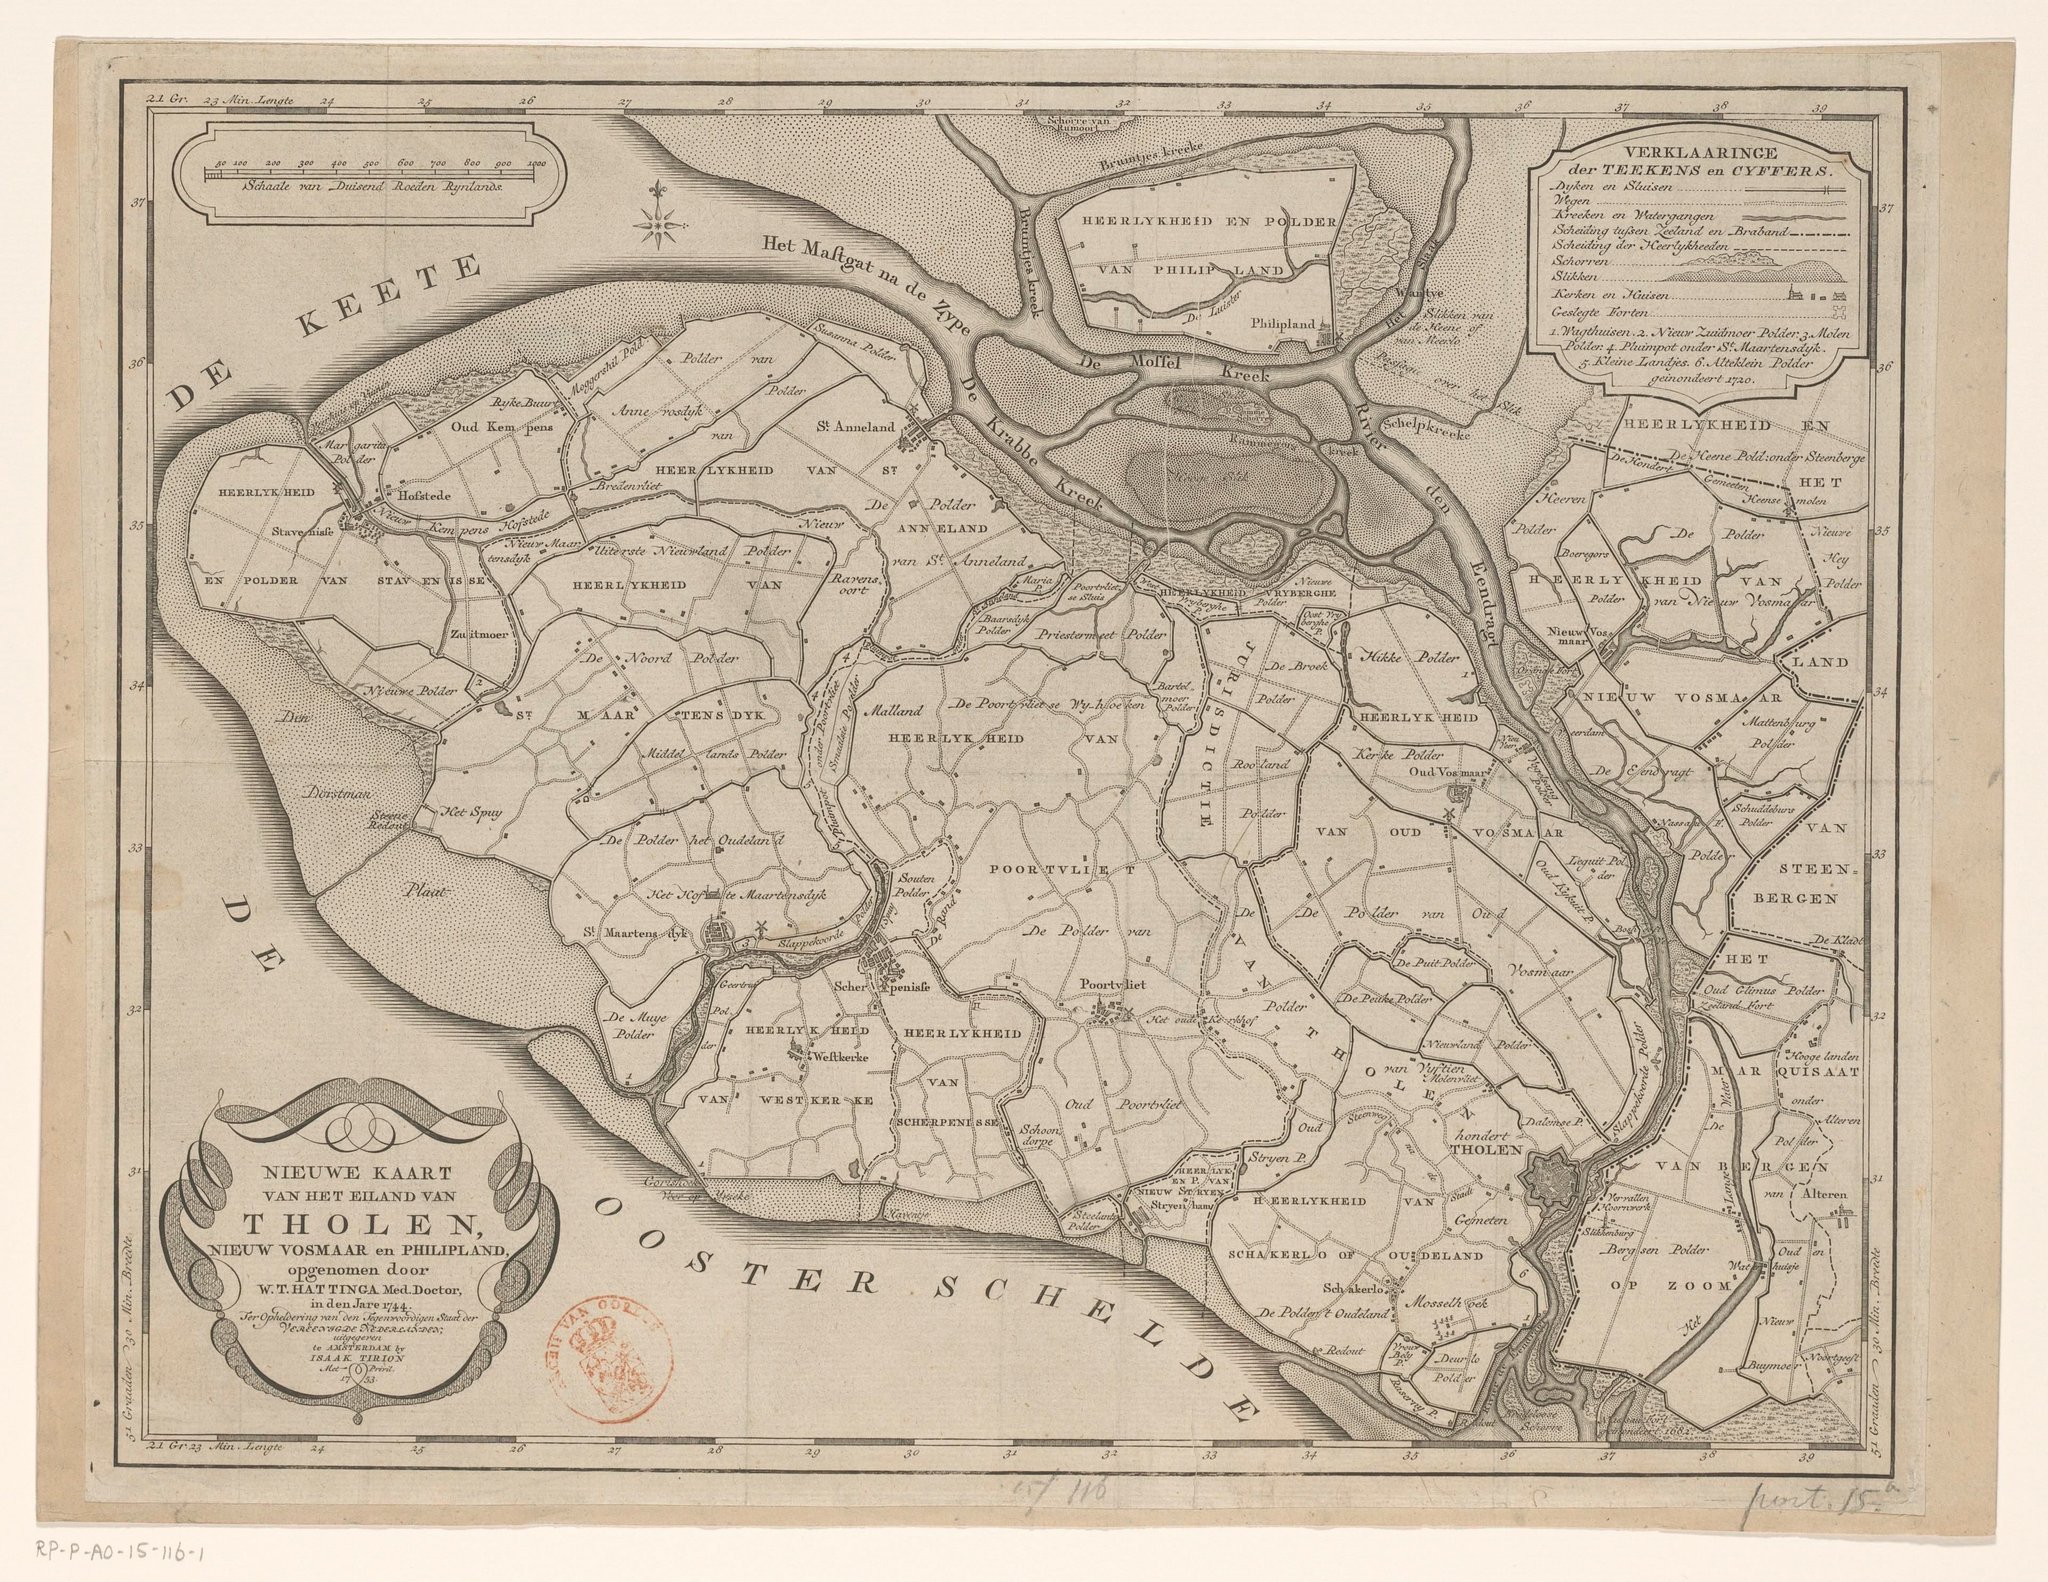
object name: map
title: Nieuwe kaart van het eiland van Tholen, Nieuw Vosmaar en Philipland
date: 1753-1760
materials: paper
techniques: engraving, etching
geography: amsterdam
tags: maps of separate countries or regions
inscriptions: collector's mark: Lugt 19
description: Linksboven een schaalstok: Schaale van duisend roeden Rynlands. Linksonder de titelcartouche. Rechtsboven een cartouche met de legenda. Gradenverdeling langs de randen.